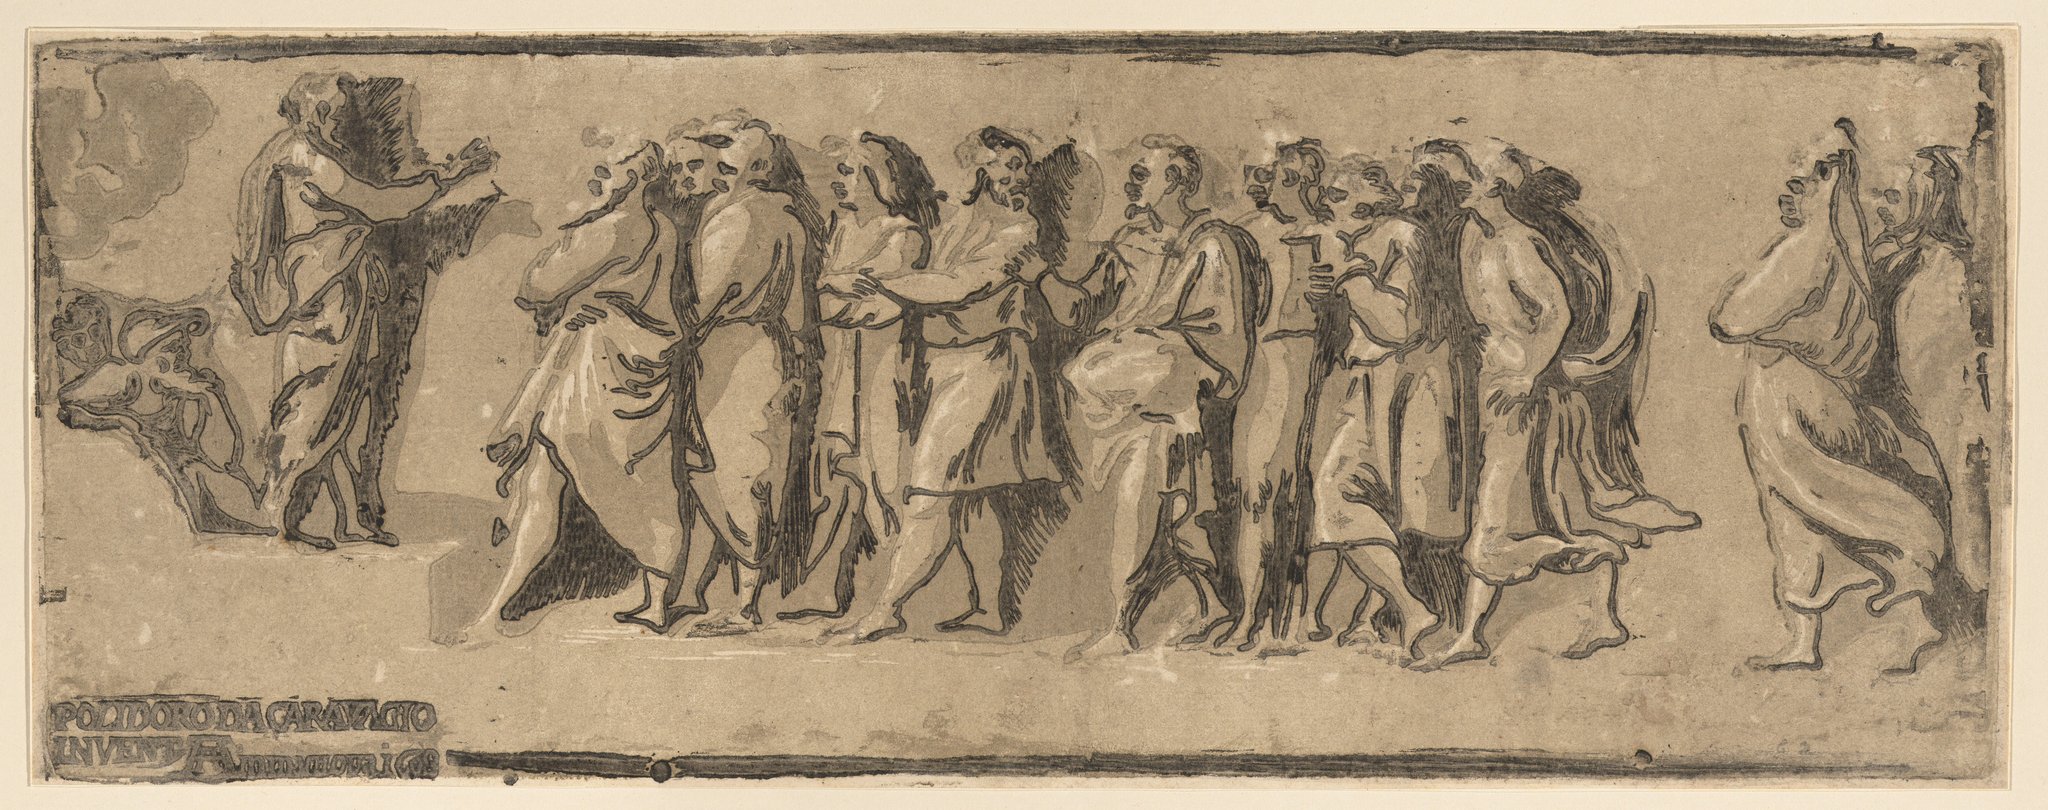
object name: print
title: Joshua addressing the people at Schechem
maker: niccolò vicentino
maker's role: artist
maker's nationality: italian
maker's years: 1510-1550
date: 1520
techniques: woodcut